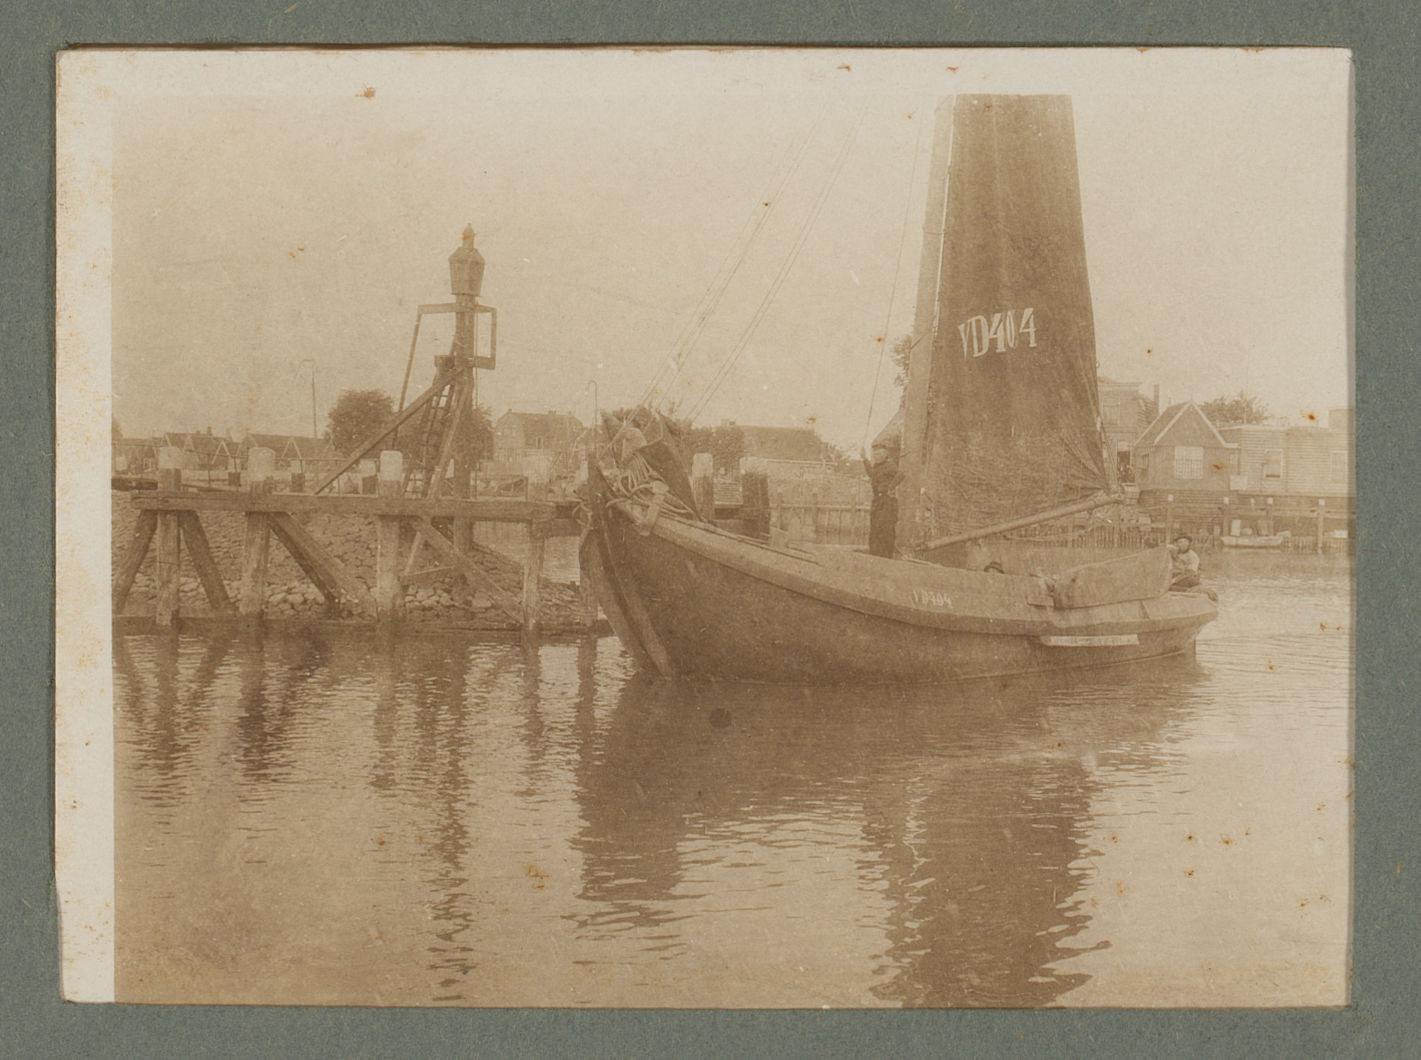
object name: photograph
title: Volendammer zeilboot in de haven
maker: george hidderley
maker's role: fotograaf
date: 1920-1940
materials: photographic support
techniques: gelatin silver print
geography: volendam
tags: sailing-ship, sailing-boat